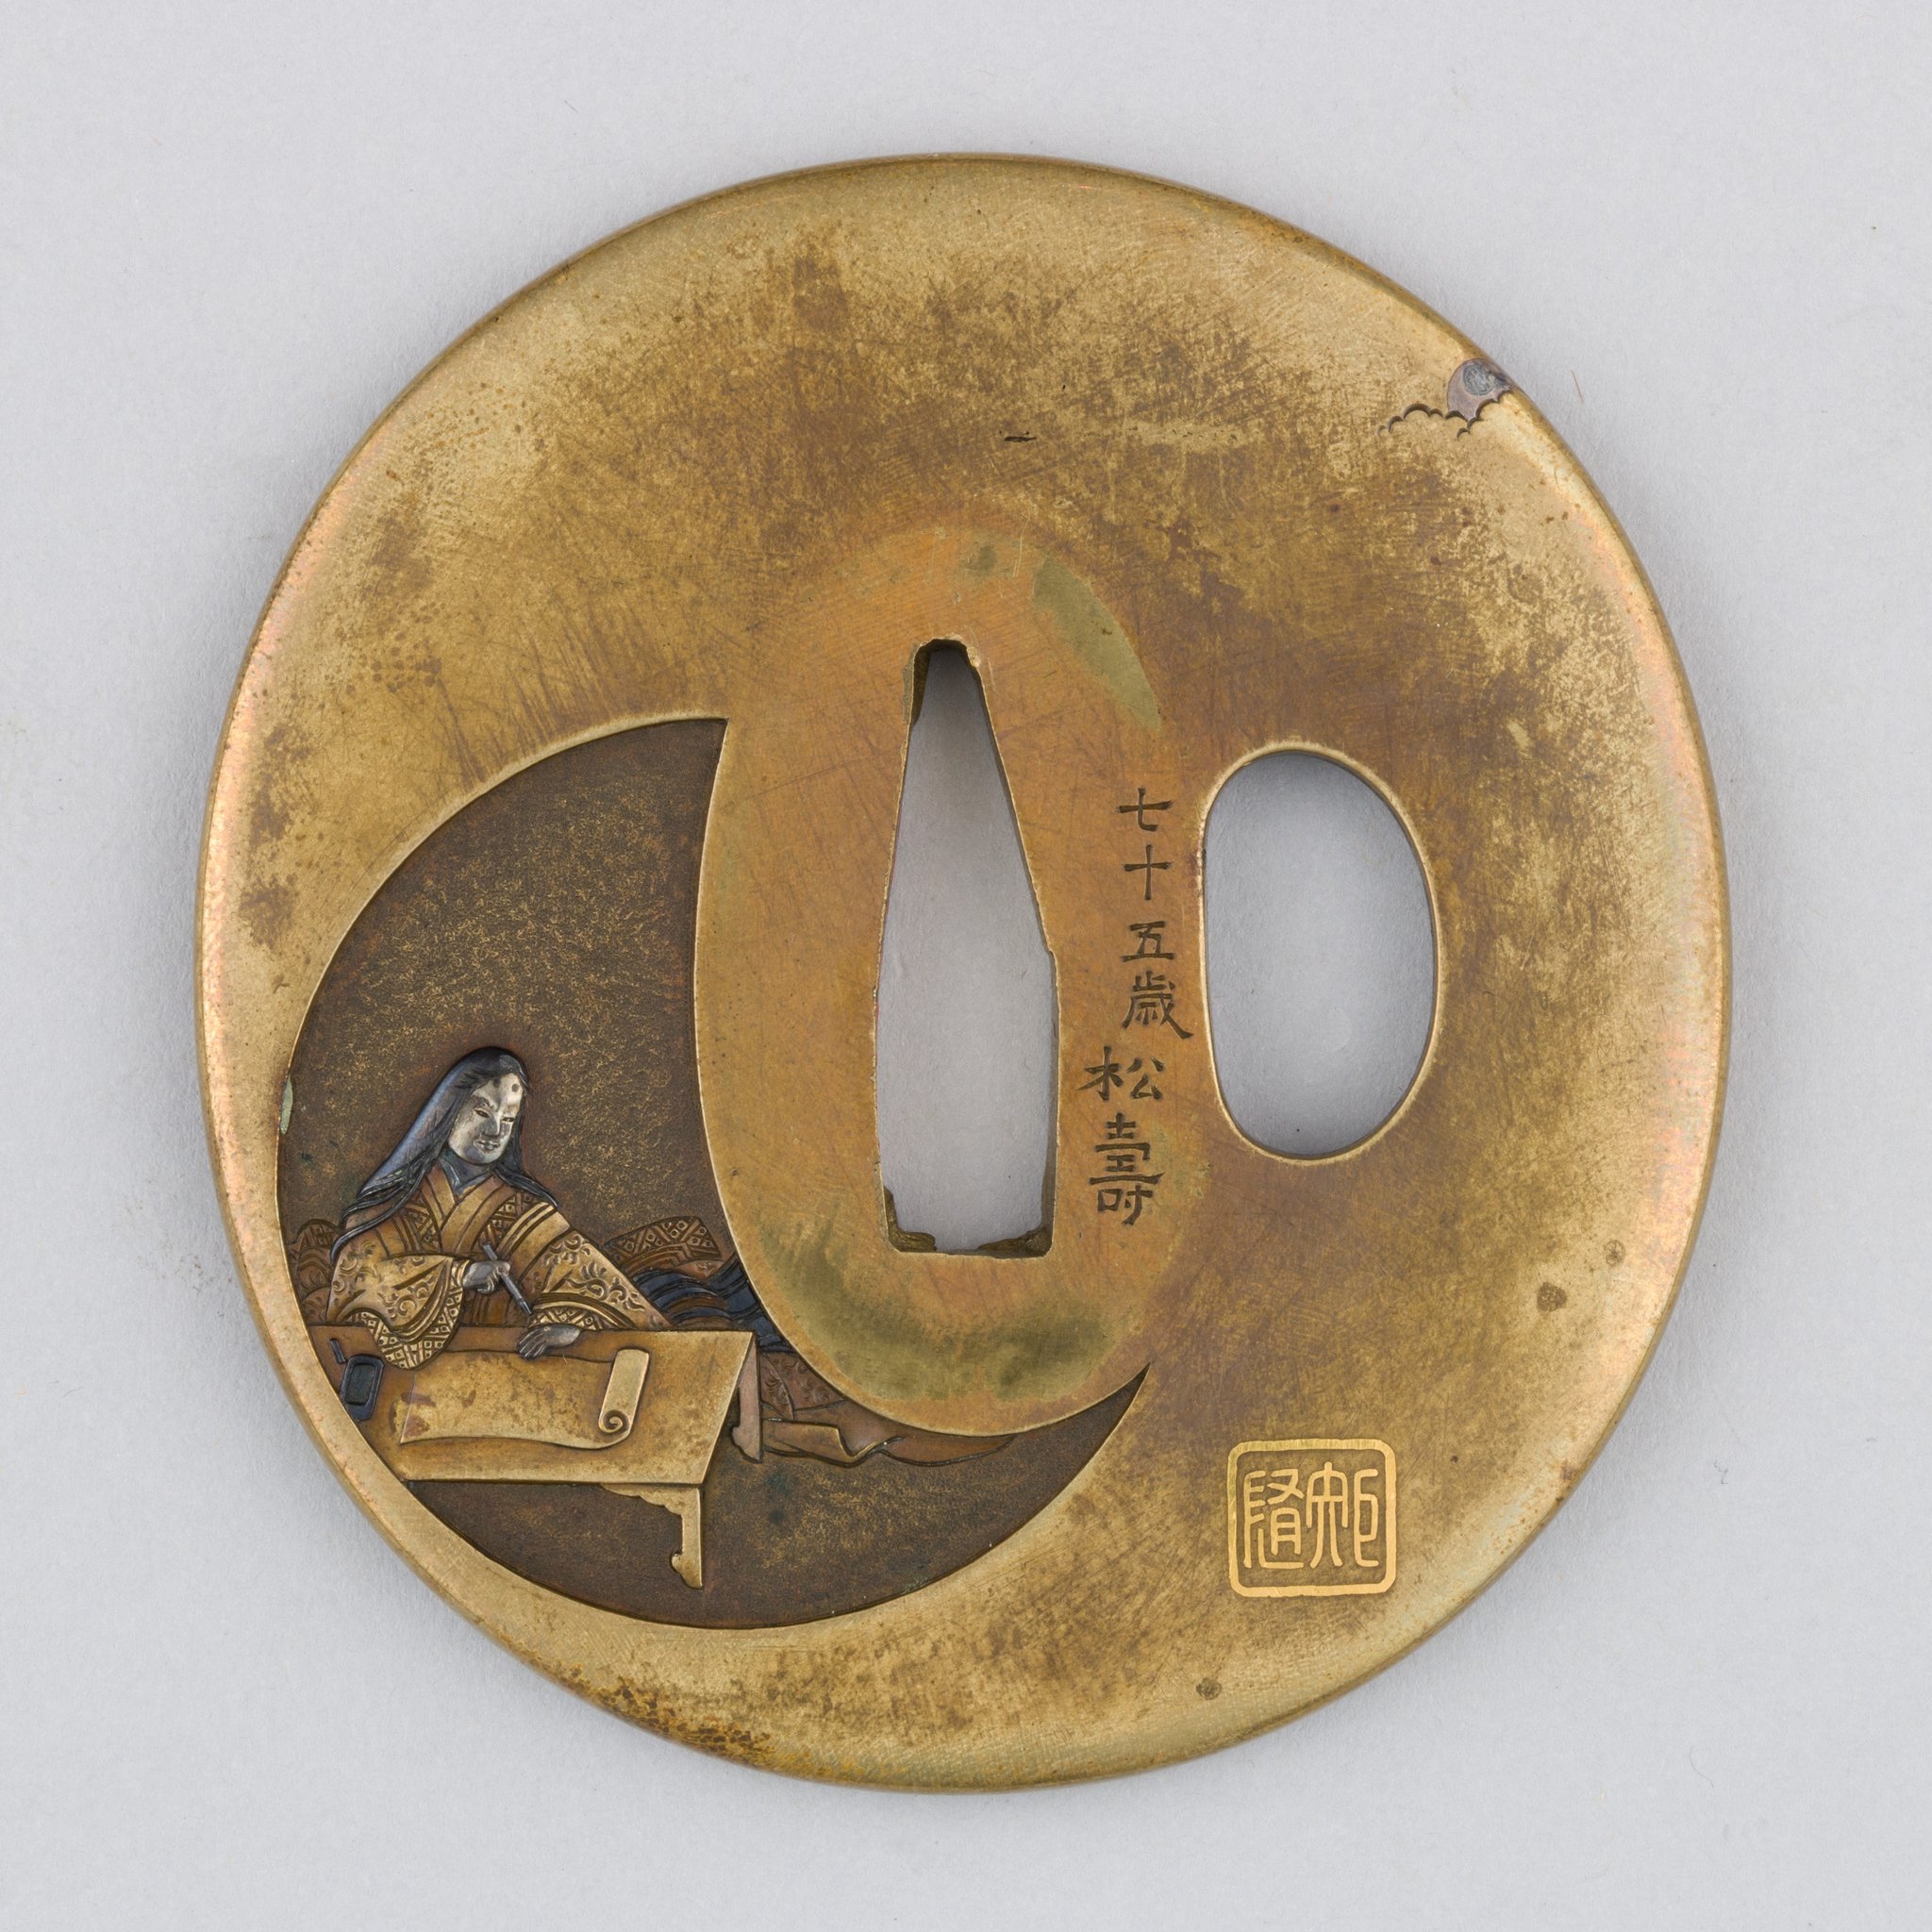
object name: sword guard tsuba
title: Sword Guard (Tsuba)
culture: japanese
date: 1701-1800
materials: bronze, copper, gold alloy, gold, silver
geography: japan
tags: human figures,writing